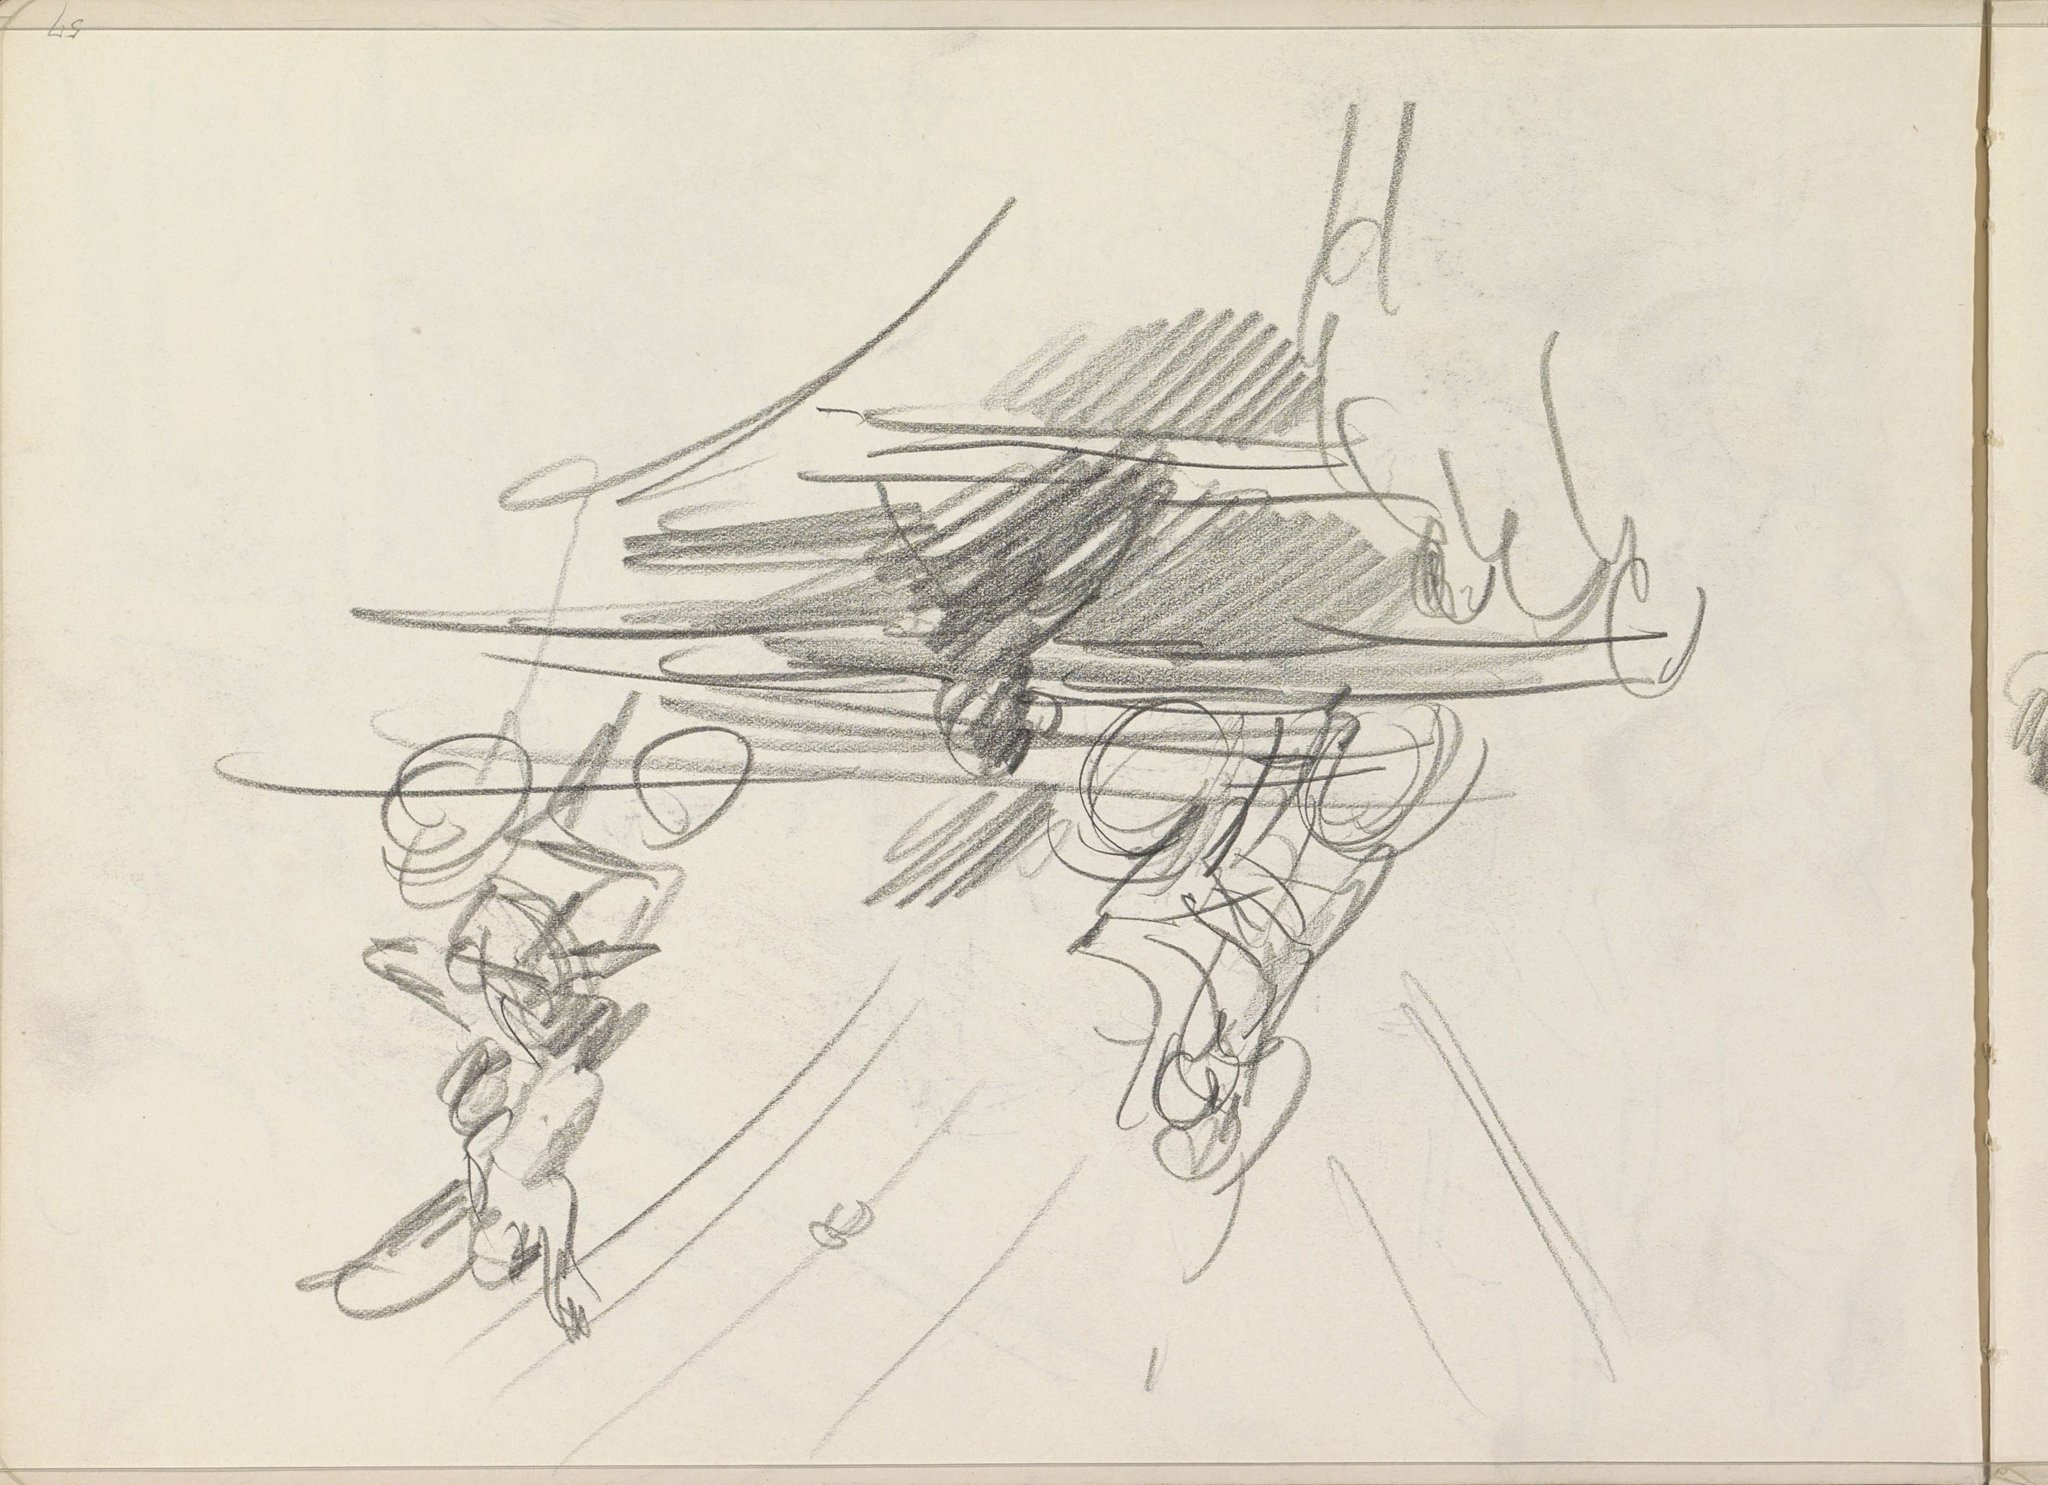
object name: sketchbook leaf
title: Fietsende acrobaten op het toneel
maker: isaac israels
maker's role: draughtsman, painter, print maker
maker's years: 1865-1934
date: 1875-1934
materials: paper, pencil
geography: the hague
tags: acrobat ~ circus, bicycle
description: Vooraan zit een acrobate op de schouders van een fietsende man. Vooraan toeschouwers en de dirigent in de orkestbak. Blad 10 verso uit schetsboek V met 33 bladen.